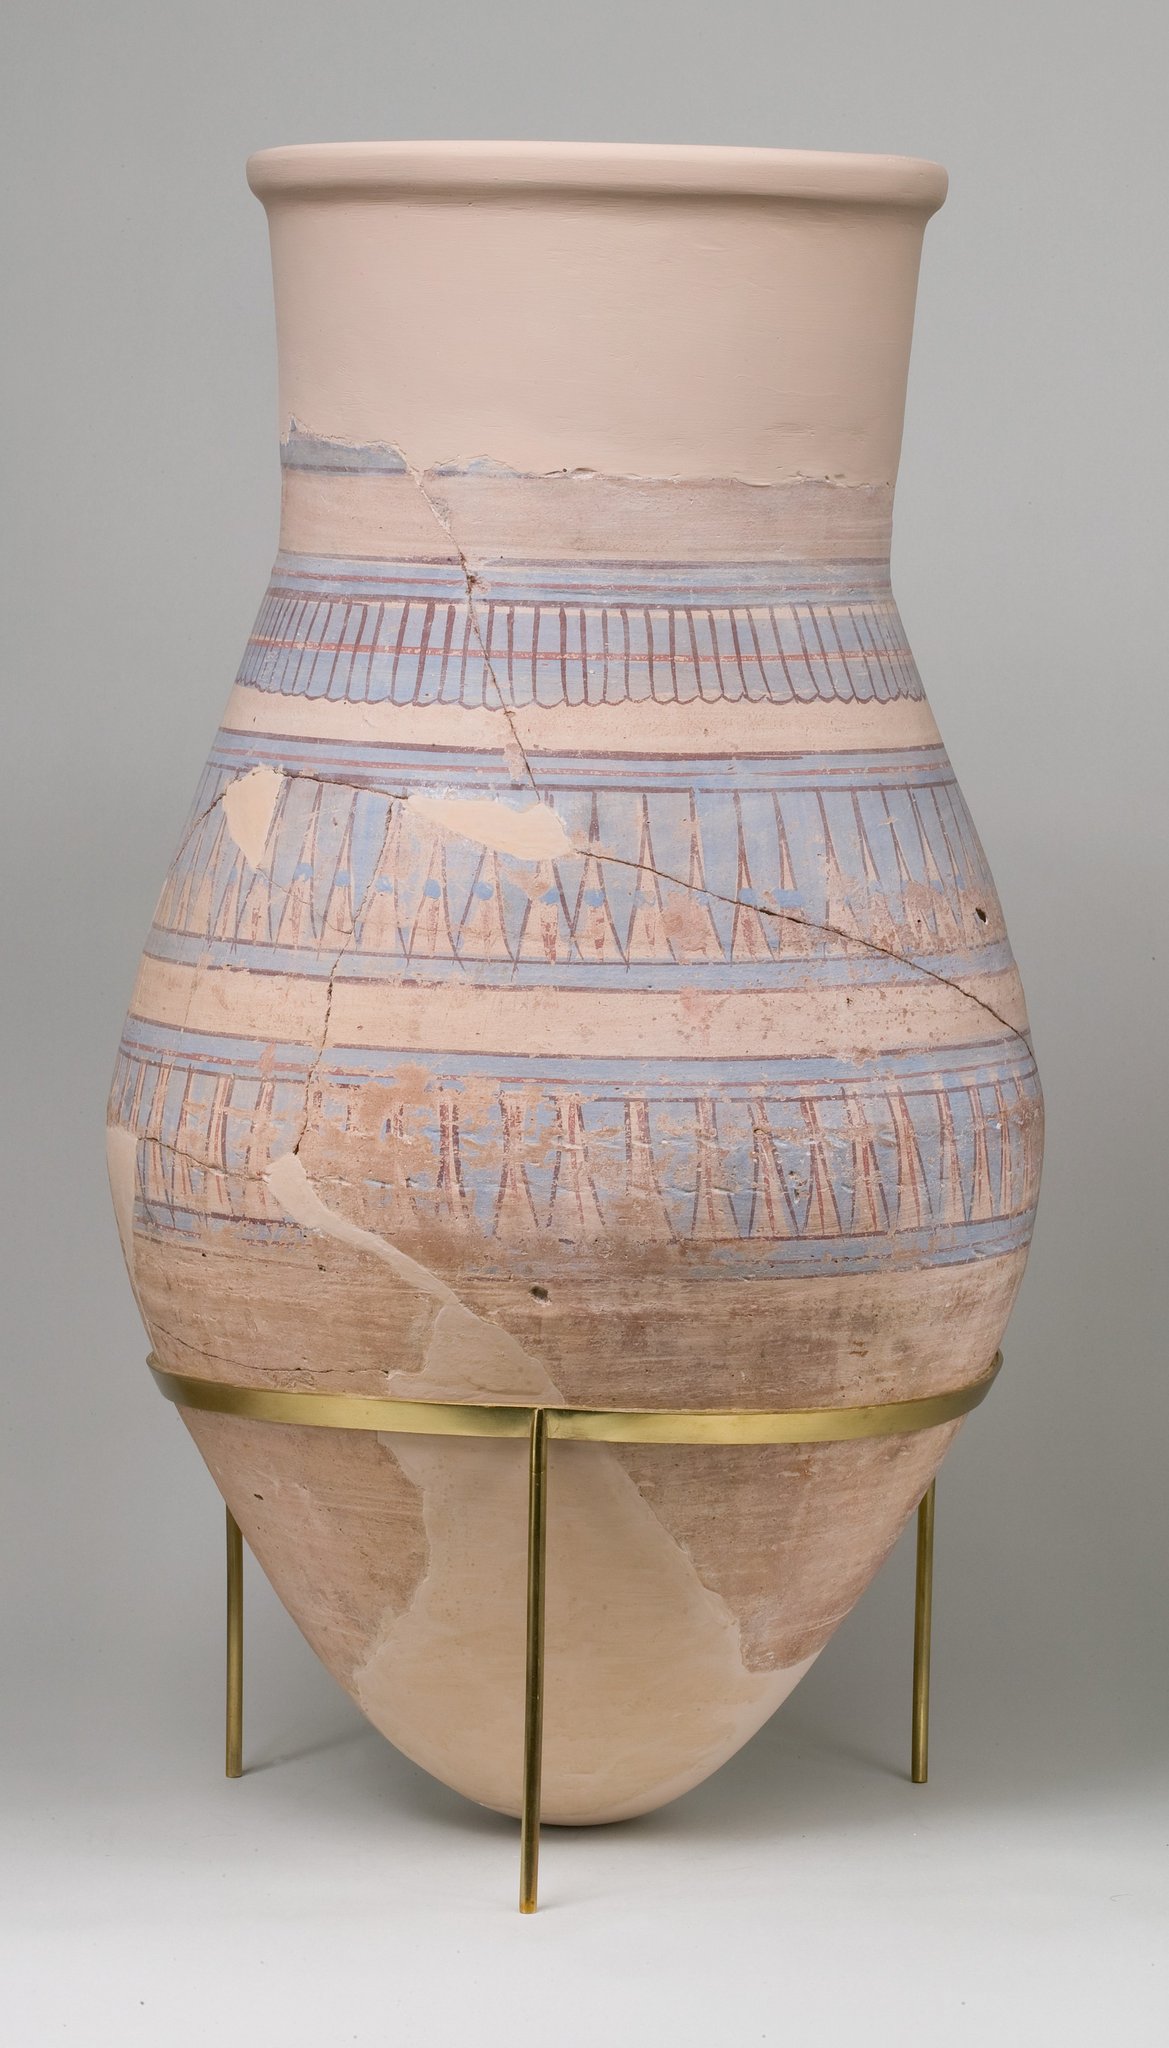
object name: jar, blue painted, malqata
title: Blue-Painted Jar from Malqata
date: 1390-1352 BCE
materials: paint, pottery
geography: egypt